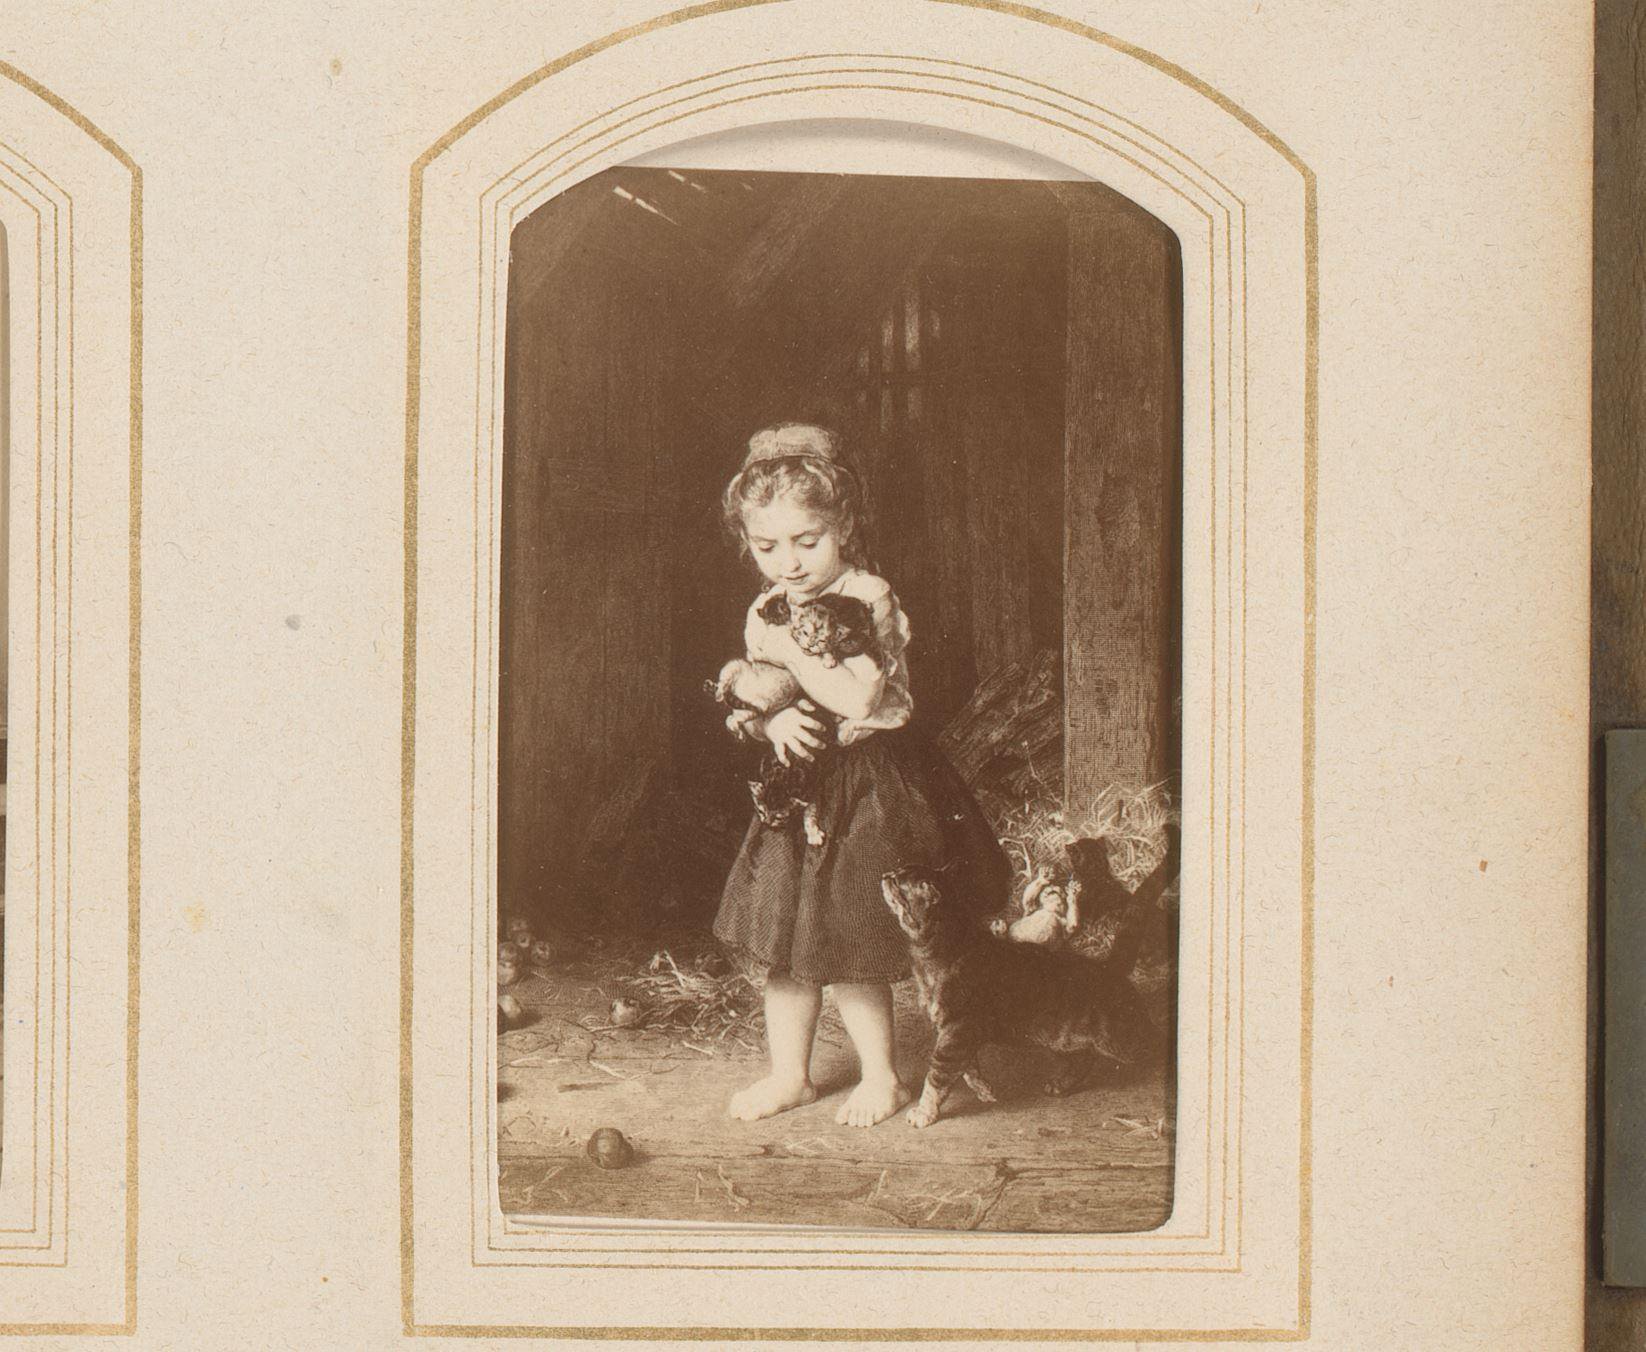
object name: reproduction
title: Fotoreproductie van een schilderij van een meisje met een kitten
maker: Anonymous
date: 1870-1890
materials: cardboard, photographic support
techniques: albumen print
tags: cat, girl (child between toddler and youth), painting, drawing and the graphic arts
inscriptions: annotation: ‘[...]’, inscription